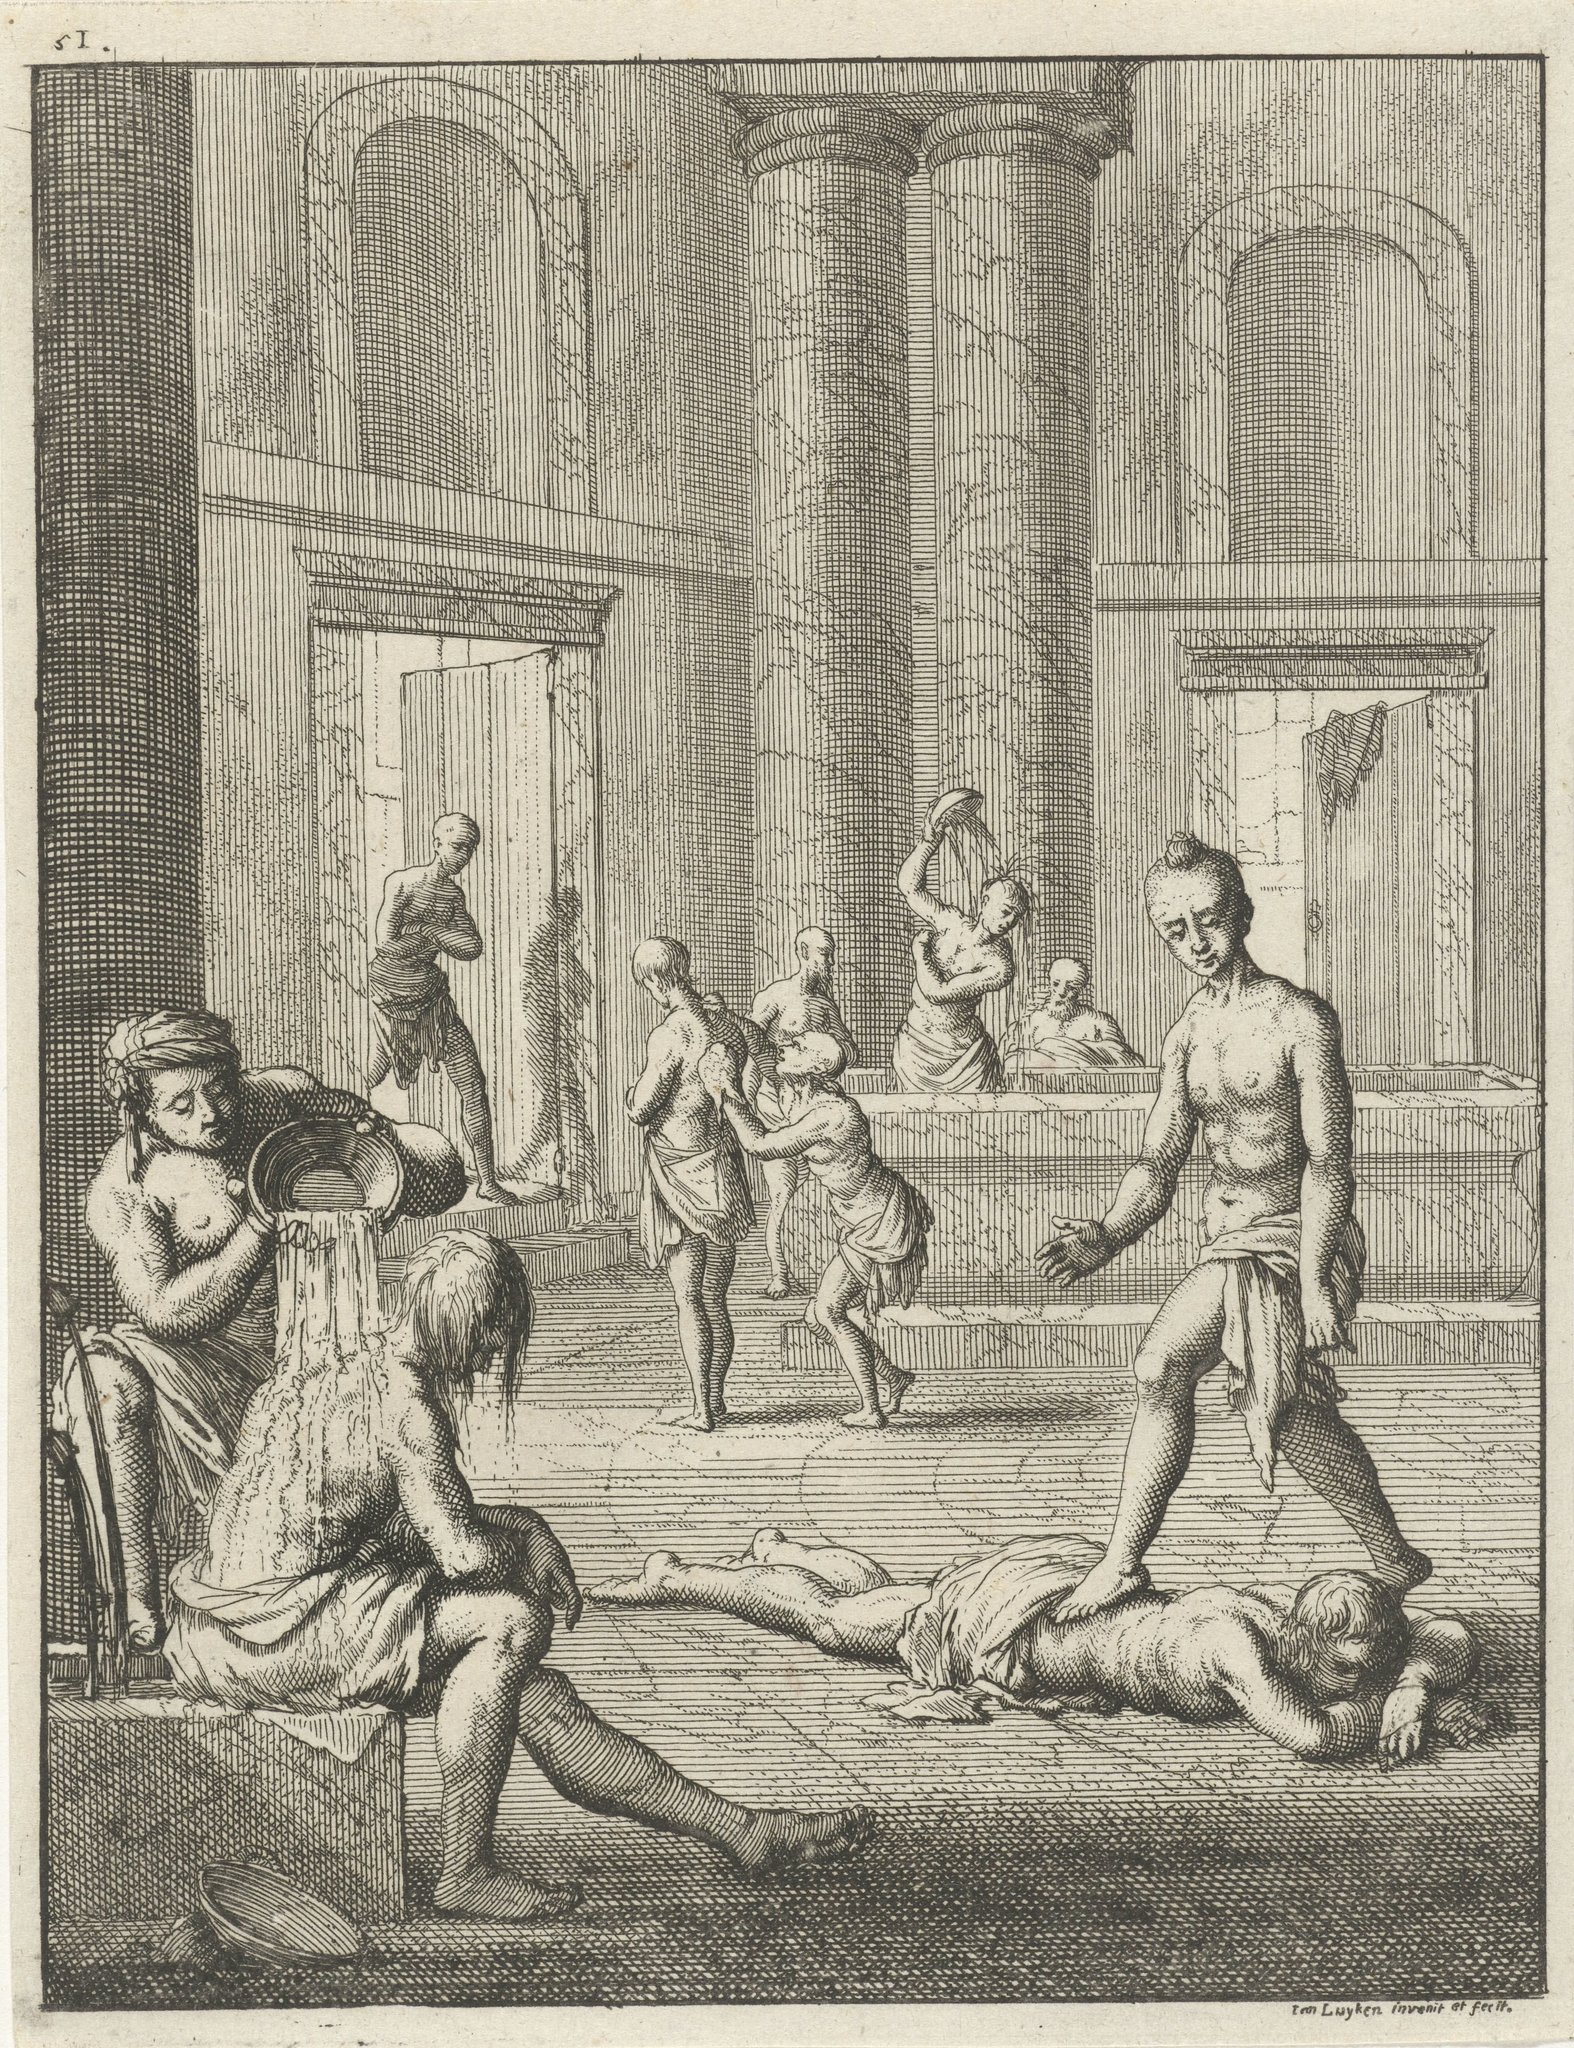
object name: print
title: Interieur van een Turks badhuis waar massages plaatsvinden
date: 1681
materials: paper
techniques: etching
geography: amsterdam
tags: 'le bain turc', public baths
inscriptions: collector's mark: Lugt 2228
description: Illustratie opgenomen in deel I van: Thevenot, Jean de. Gedenkwaardige en zeer naauwkeurige reizen van den heere de Thevenot. Amsterdam: Jan Bouman, 1681-1682.